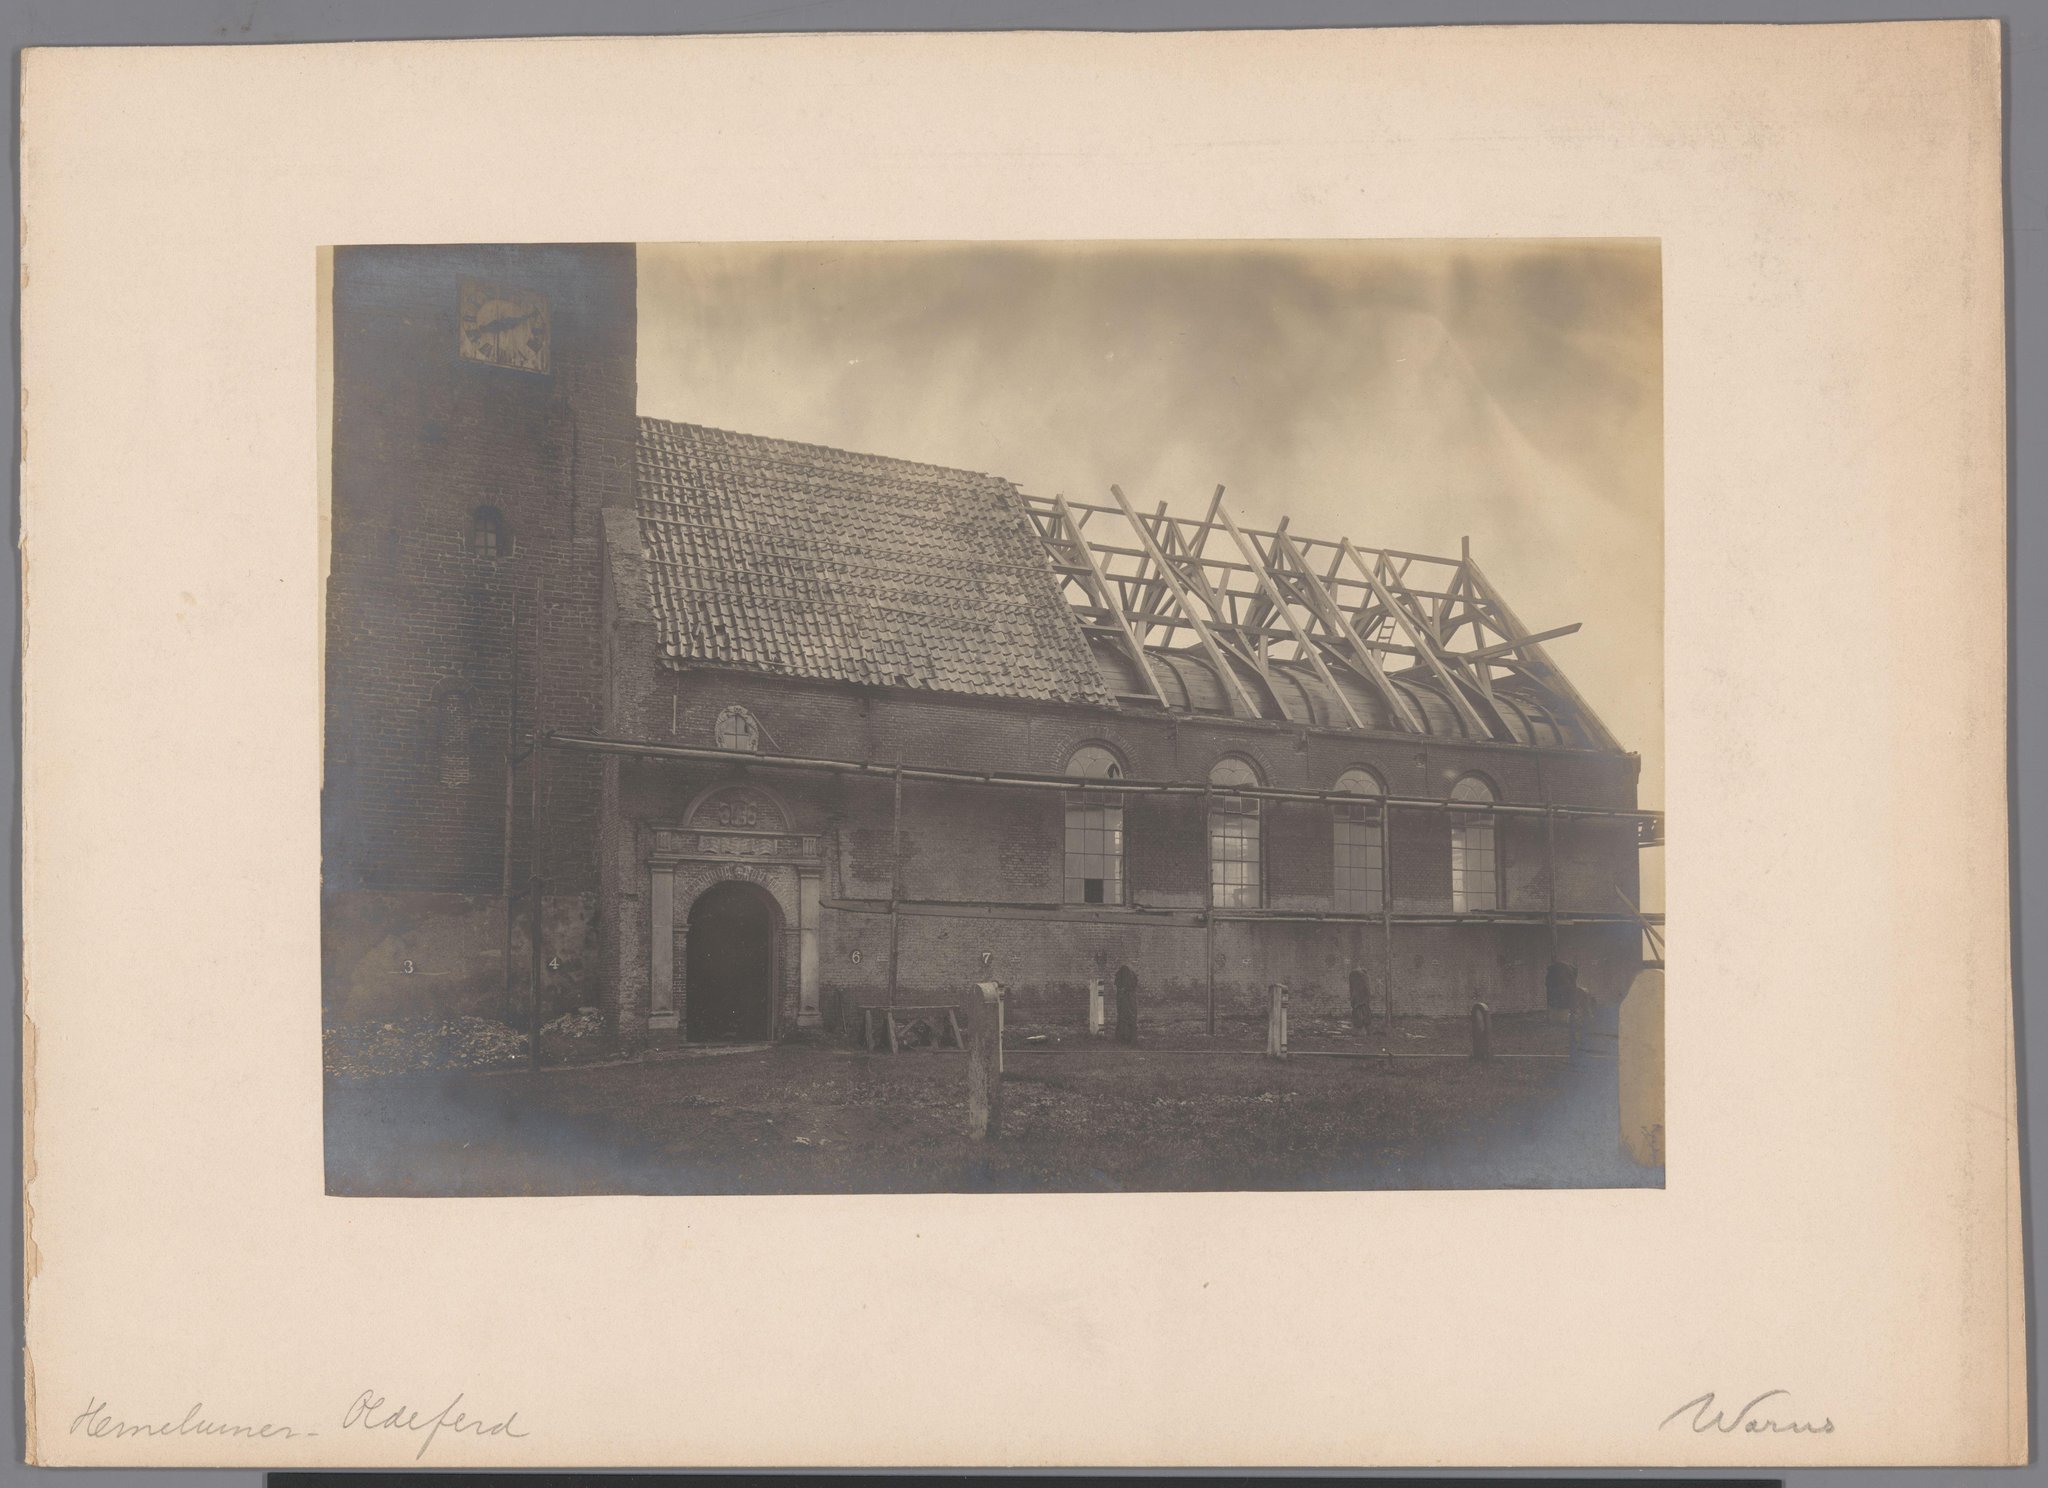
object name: photograph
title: Johannes de Doperkerk te Warns, tijdens herstelwerkzaamheden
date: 1907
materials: cardboard, photographic support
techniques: gelatin silver print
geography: warns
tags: church (exterior)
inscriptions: annotation: ‘Warns bij Stavoren (Fr.) / N.H. Kerk / Oct 1907’, annotation: ‘[...]/ Warns’